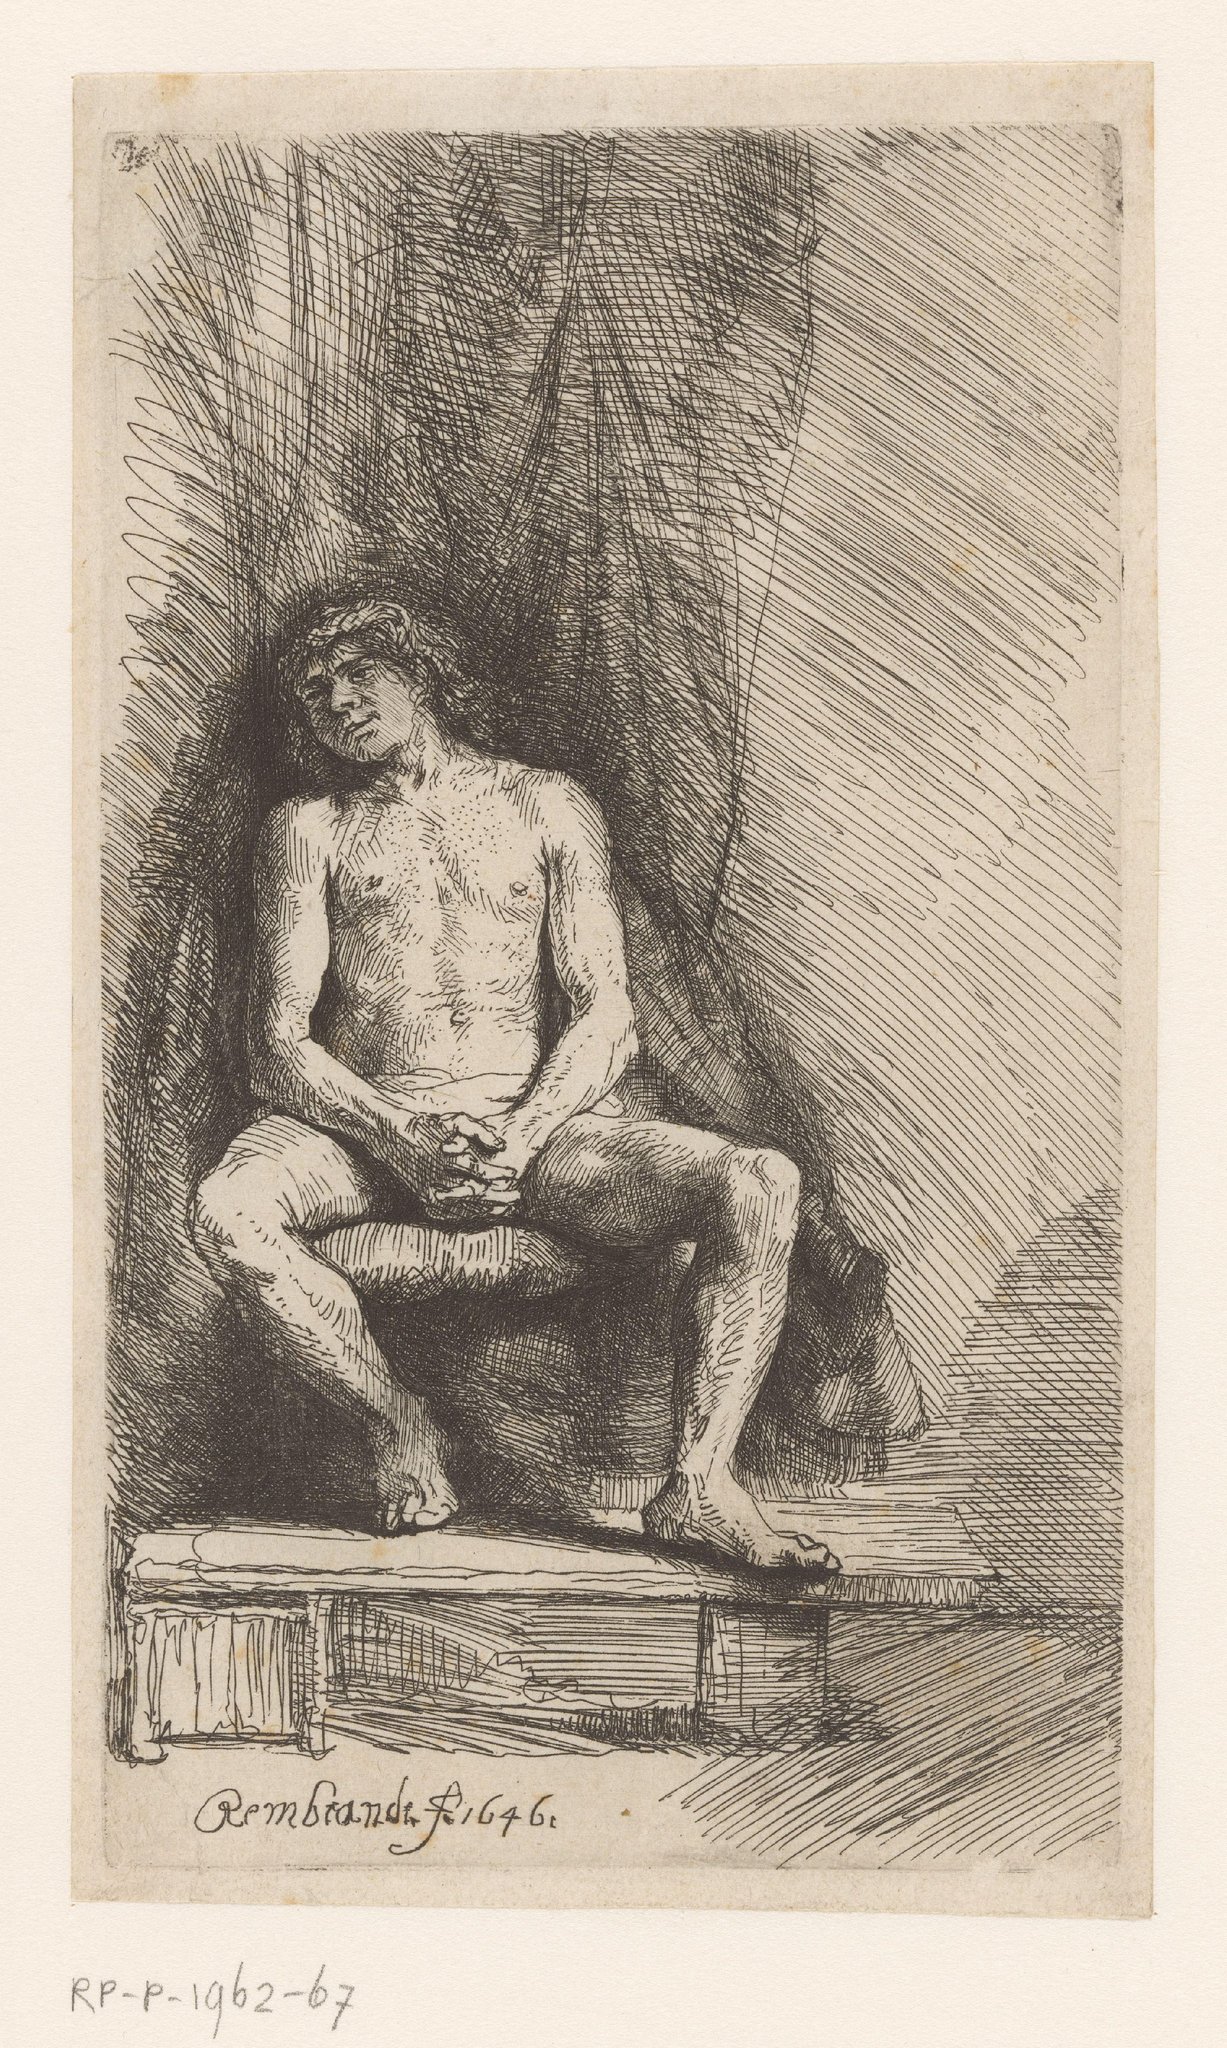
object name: print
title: Nude man seated before a curtain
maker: rembrandt van rijn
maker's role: draughtsman, painter, print maker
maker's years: 1606-1669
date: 1646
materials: paper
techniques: etching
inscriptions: signature and date: ‘Rembrandt f. 1646’, mark: Lugt 2475, mark: Lugt 2228, mark: Lugt 1185